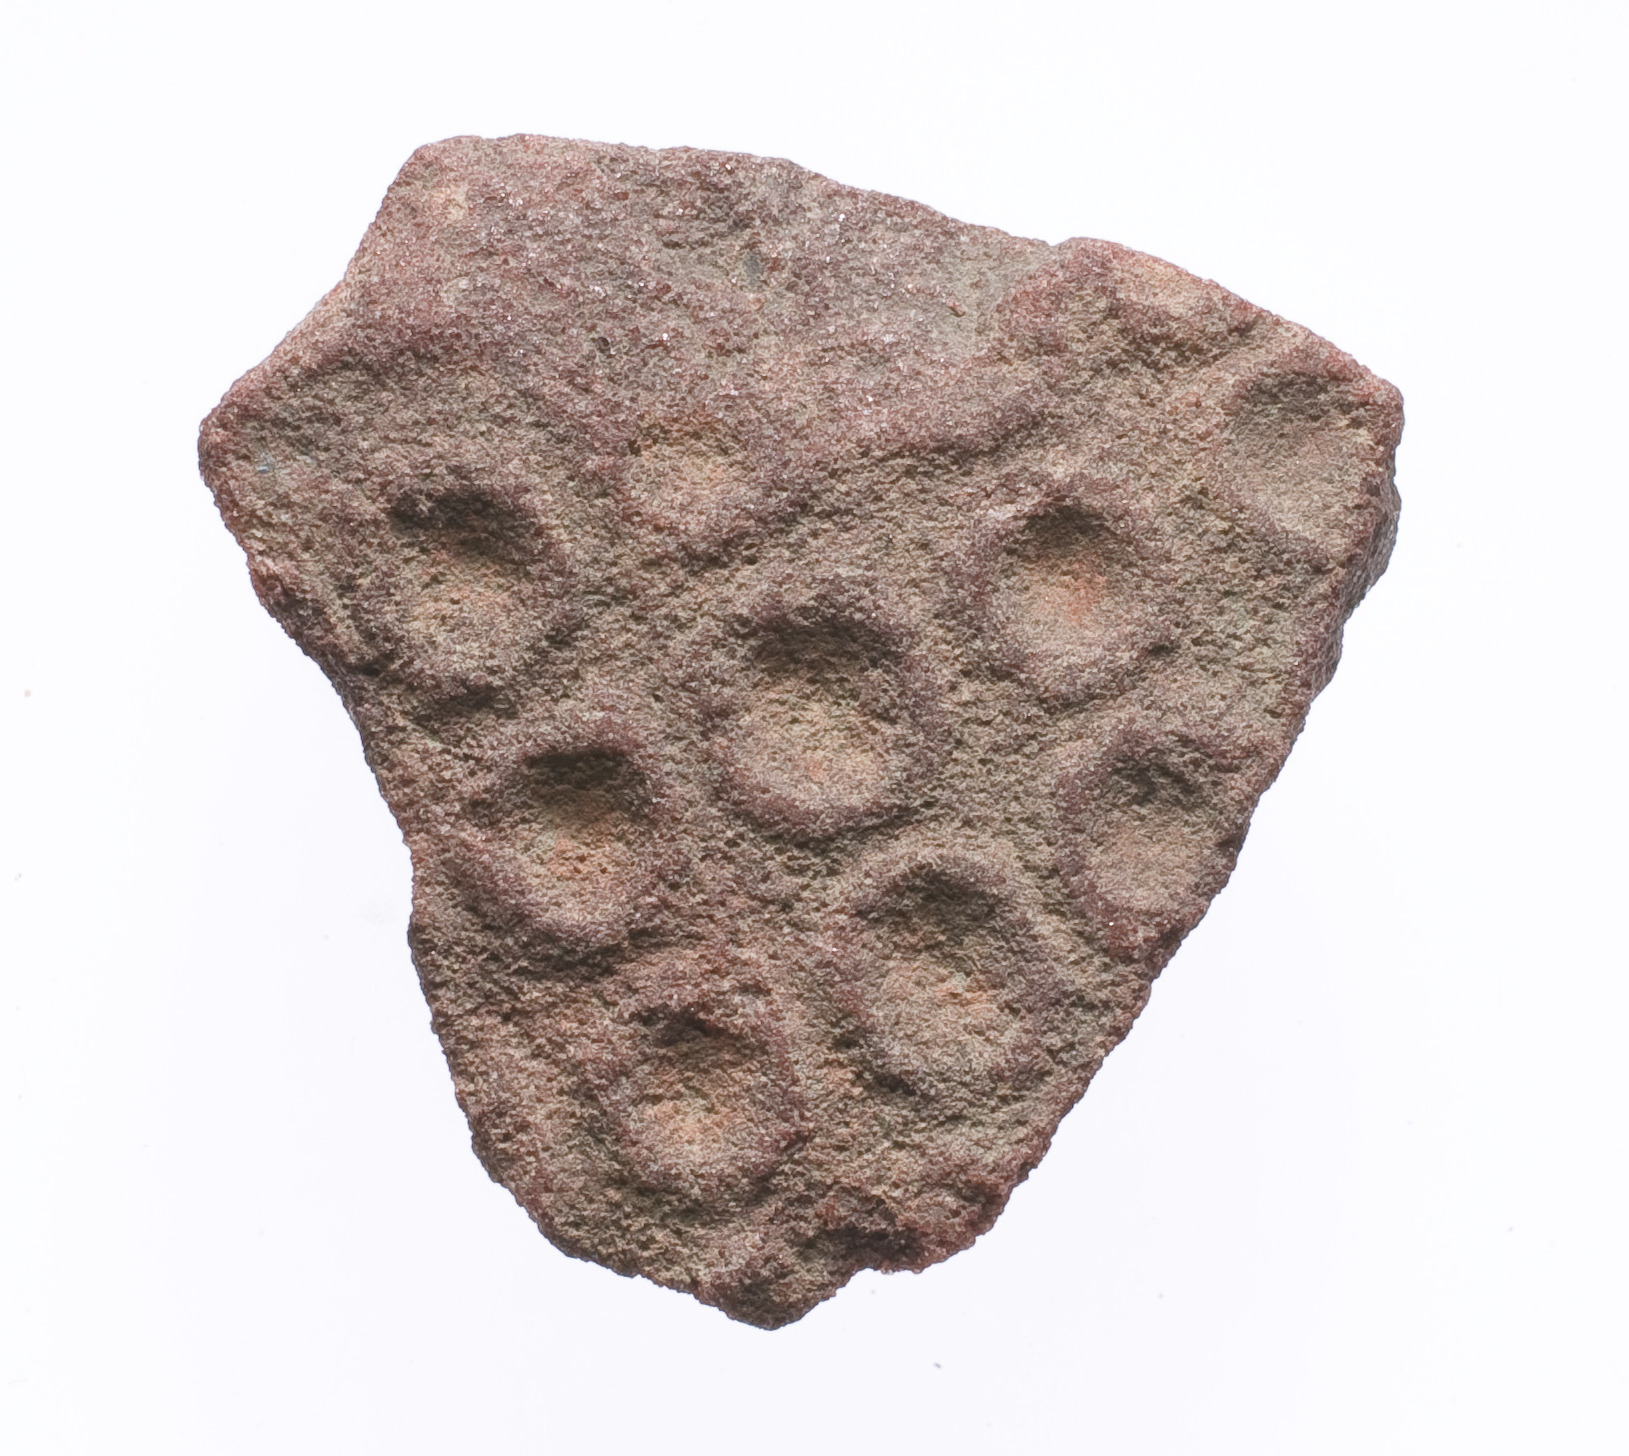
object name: crown with disc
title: Crown with discs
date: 1353-1336 BCE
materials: quartzite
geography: egypt